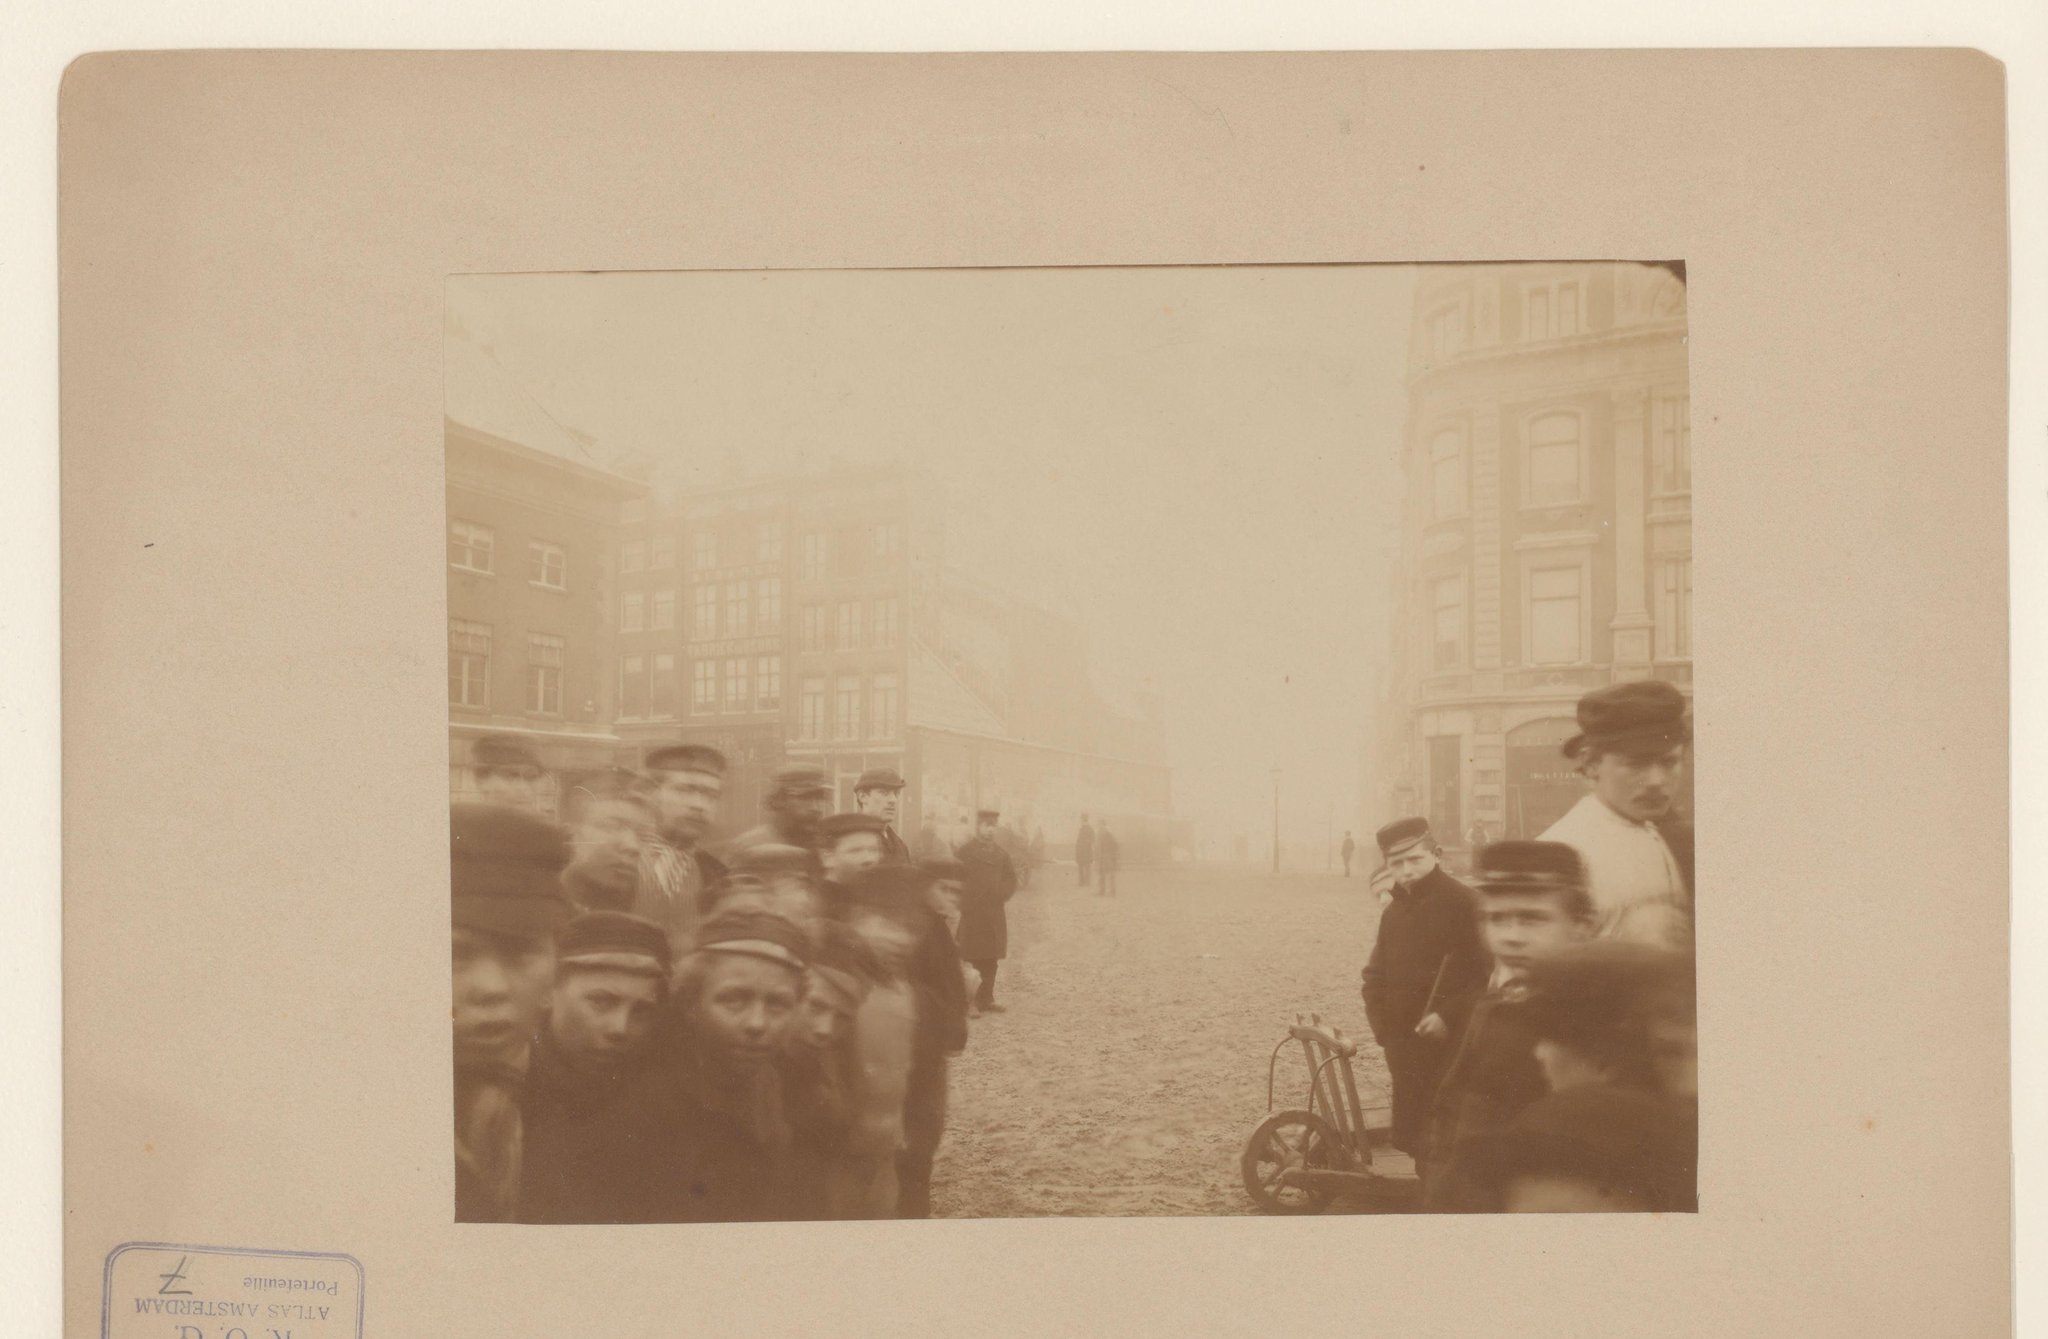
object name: photograph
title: Gezicht op de Dam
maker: Anonymous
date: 1860-1900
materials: cardboard, paper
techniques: albumen print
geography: amsterdam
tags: square, place, circus, etc., city-view in general; 'veduta'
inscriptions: inscription: ‘Dam’, collector's mark: ‘7’ Lugt 1641b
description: Onderwerpsrubriek binnen de Atlas Amsterdam: Dam (na 1835).